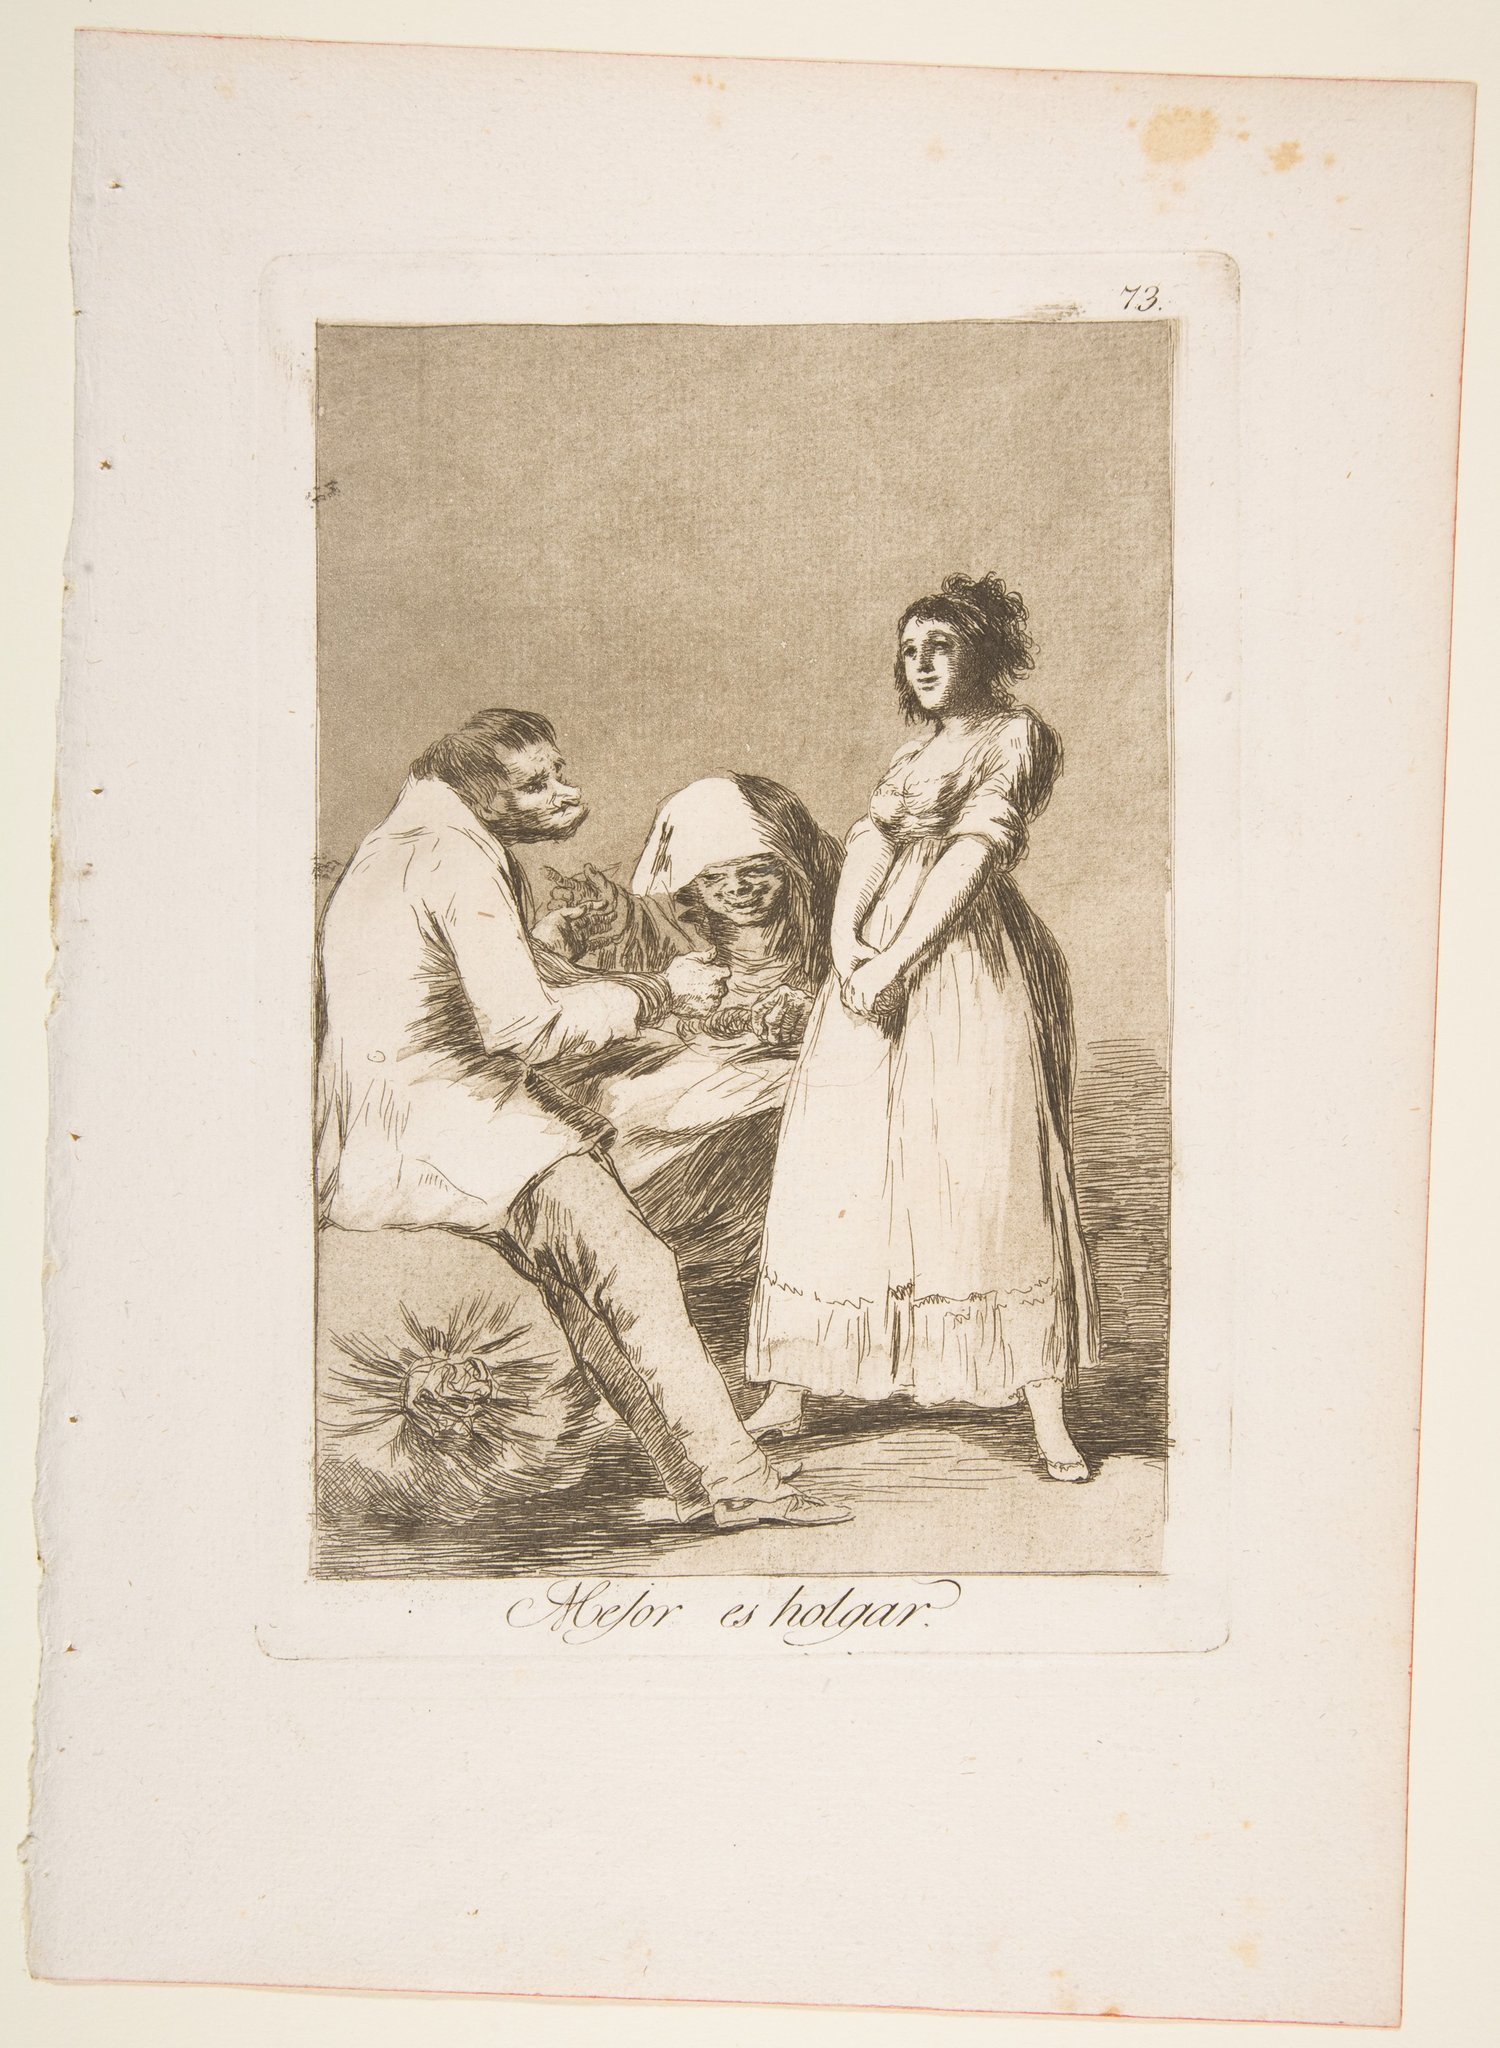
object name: print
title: Plate 73 from "Los Caprichos": It is better to be lazy (Mejor es holgar)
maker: goya (francisco de goya y lucientes)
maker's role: artist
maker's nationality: spanish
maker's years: 1746-1828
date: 1799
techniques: aquatint, engraving, burnishing, etching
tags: men,women